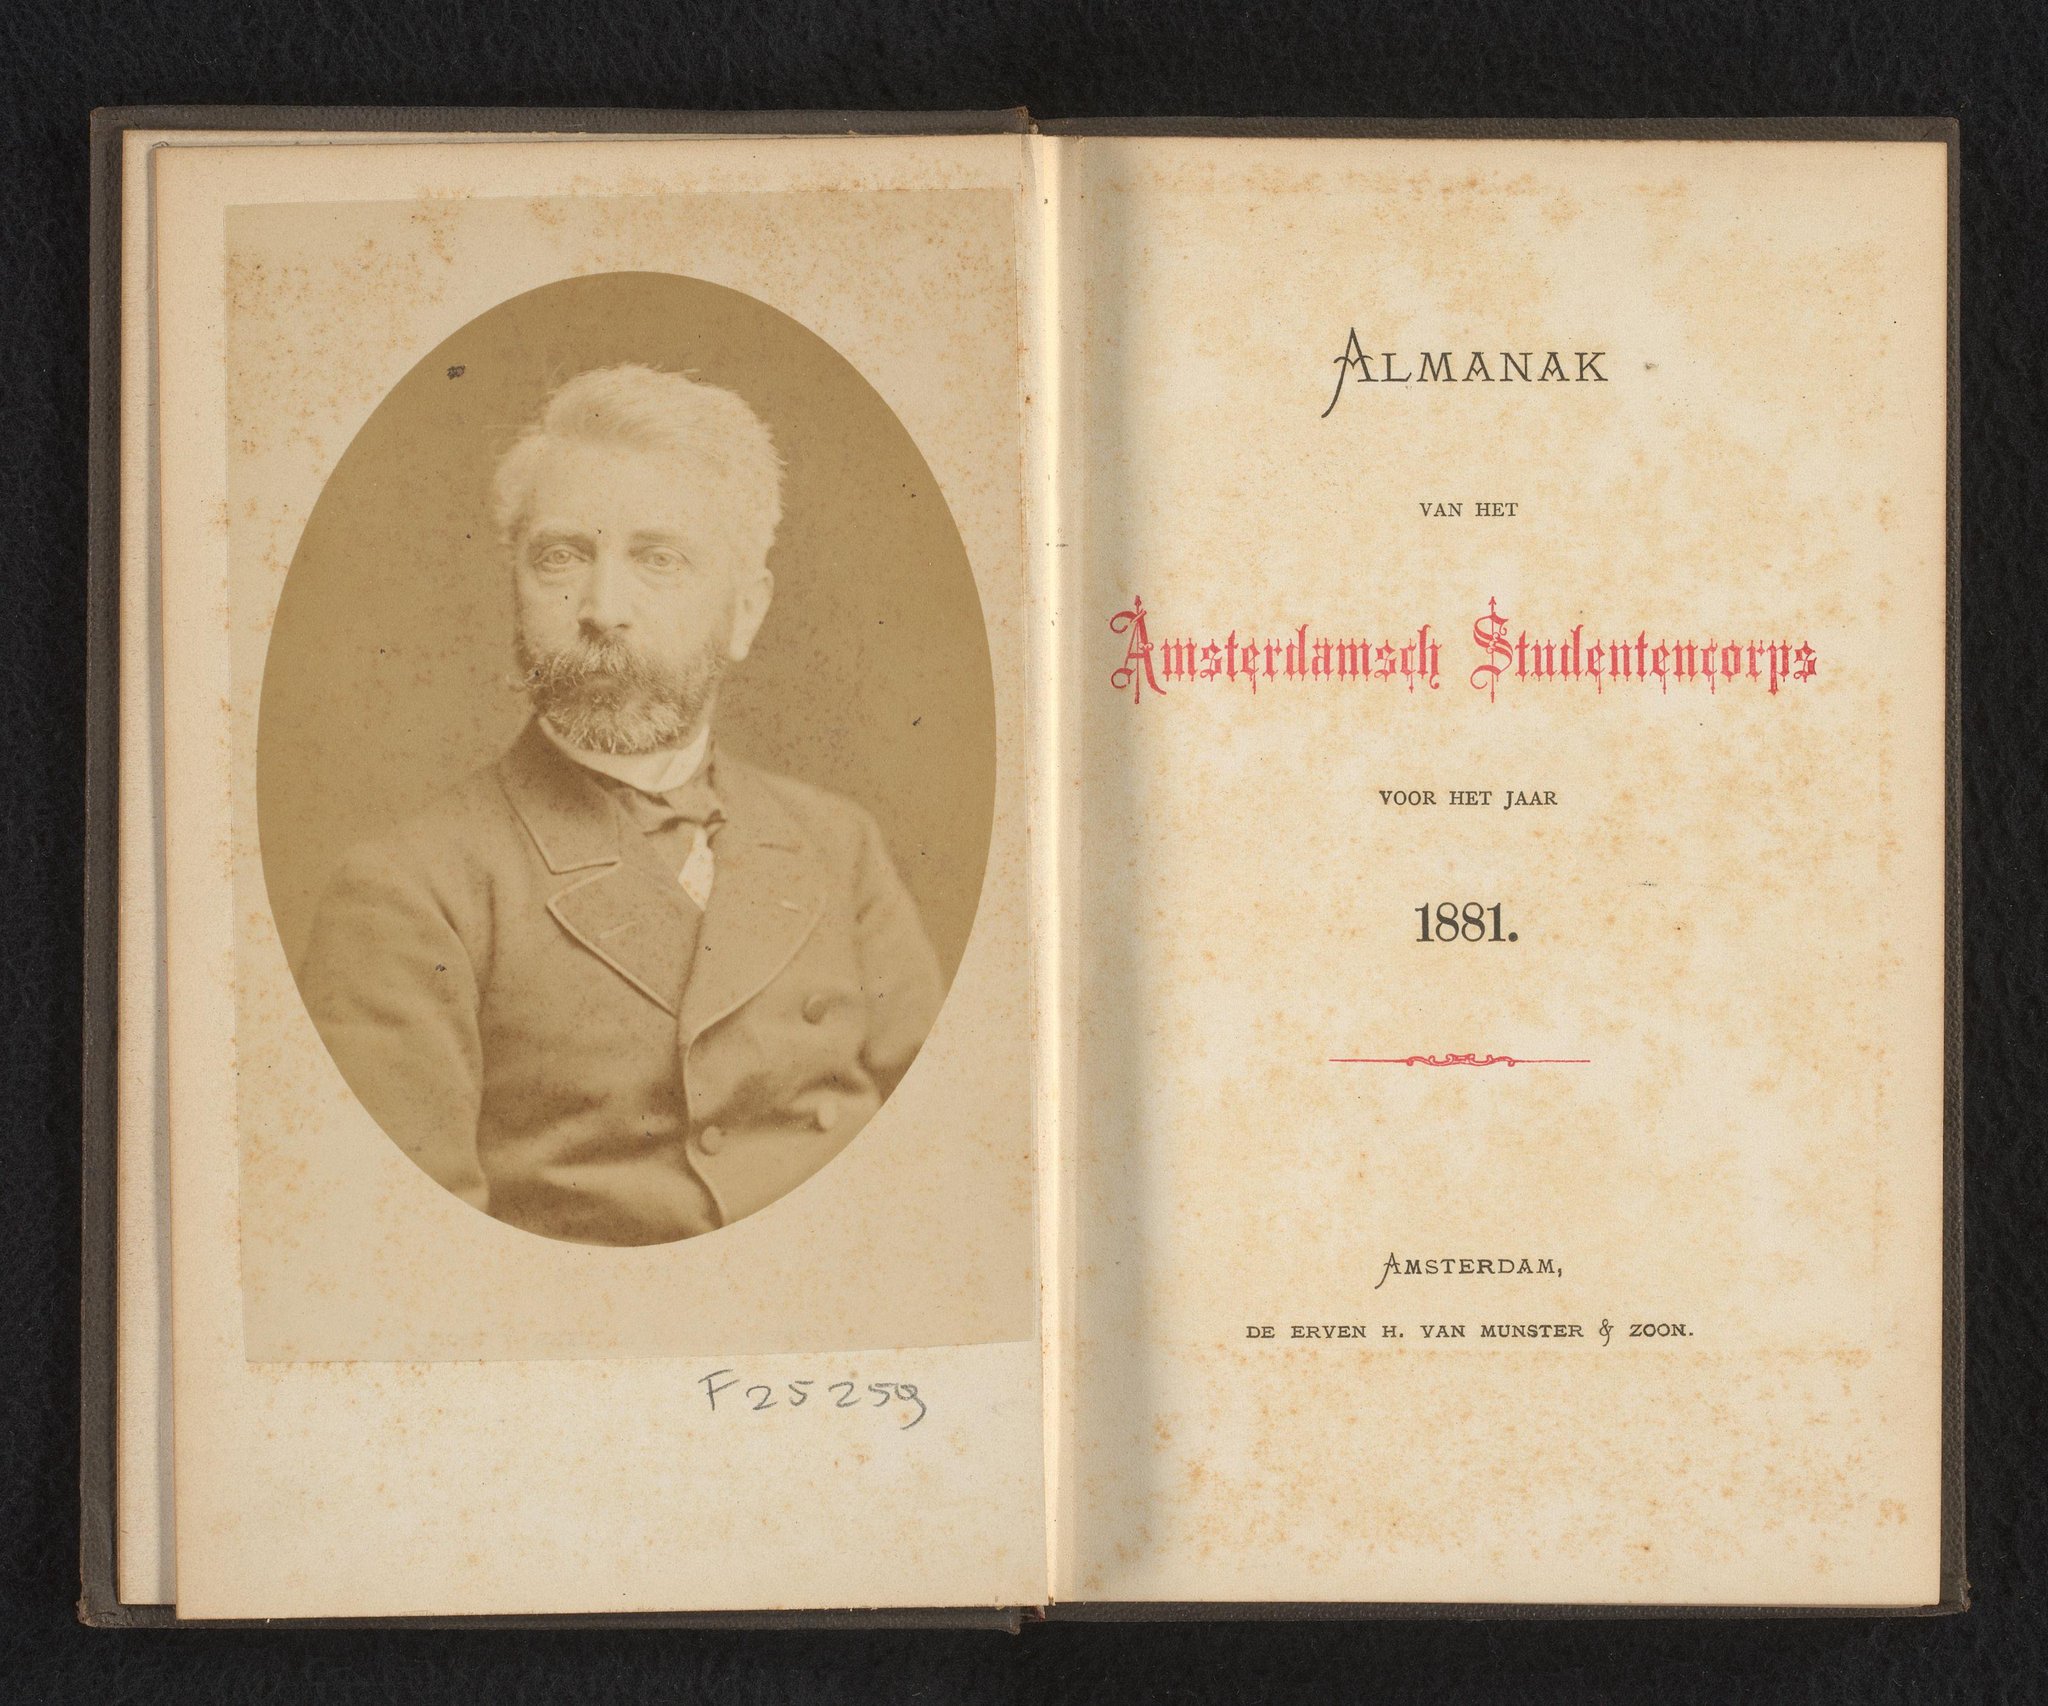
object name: page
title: Portret van een onbekende hoogleraar aan de Universiteit van Amsterdam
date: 1876-1881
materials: paper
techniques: albumen print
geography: amsterdam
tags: professor, historical persons not known by name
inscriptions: inscription: ‘Photographie Française./ Warmoesstraat, 147./ Amsterdam.’